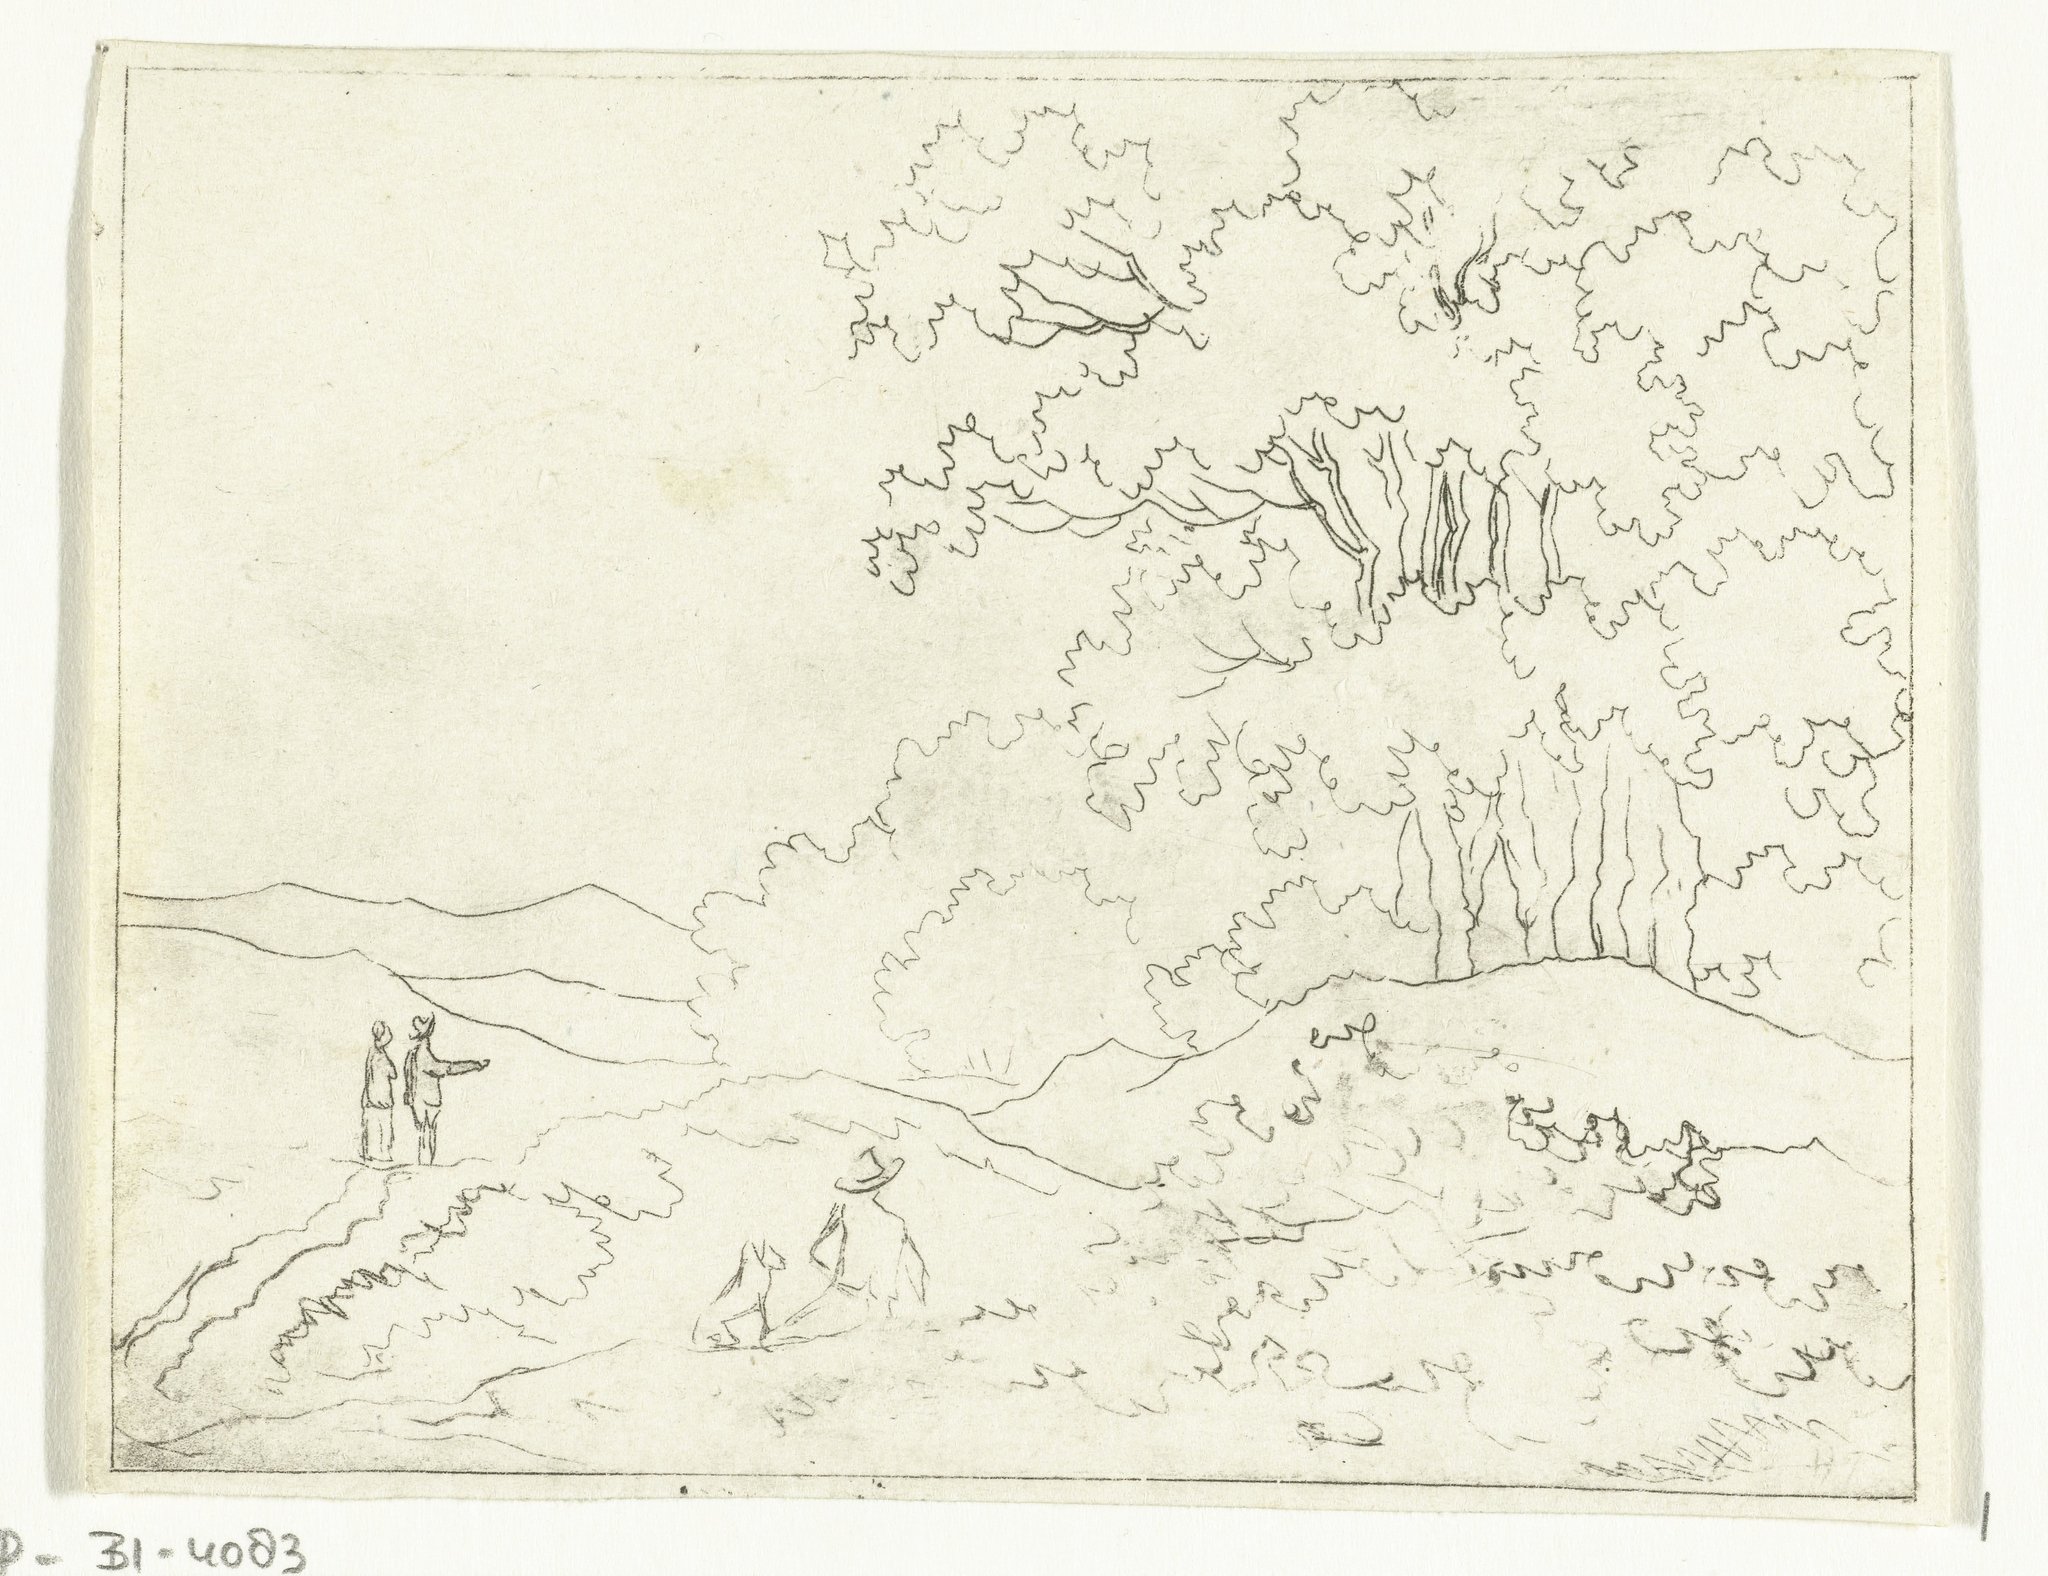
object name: print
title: Duinlandschap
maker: anthonie van den bos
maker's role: draughtsman, print maker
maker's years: 1763-1838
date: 1778-1838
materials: paper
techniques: etching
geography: netherlands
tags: dunes (sea not visible); in the dunes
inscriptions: collector's mark: Lugt 2228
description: Twee wandelaars lopen op een pad door de duinen. Een derde wandelaar rust uit. Hij zit met zijn hond op de grond en kijkt naar een groep bomen.